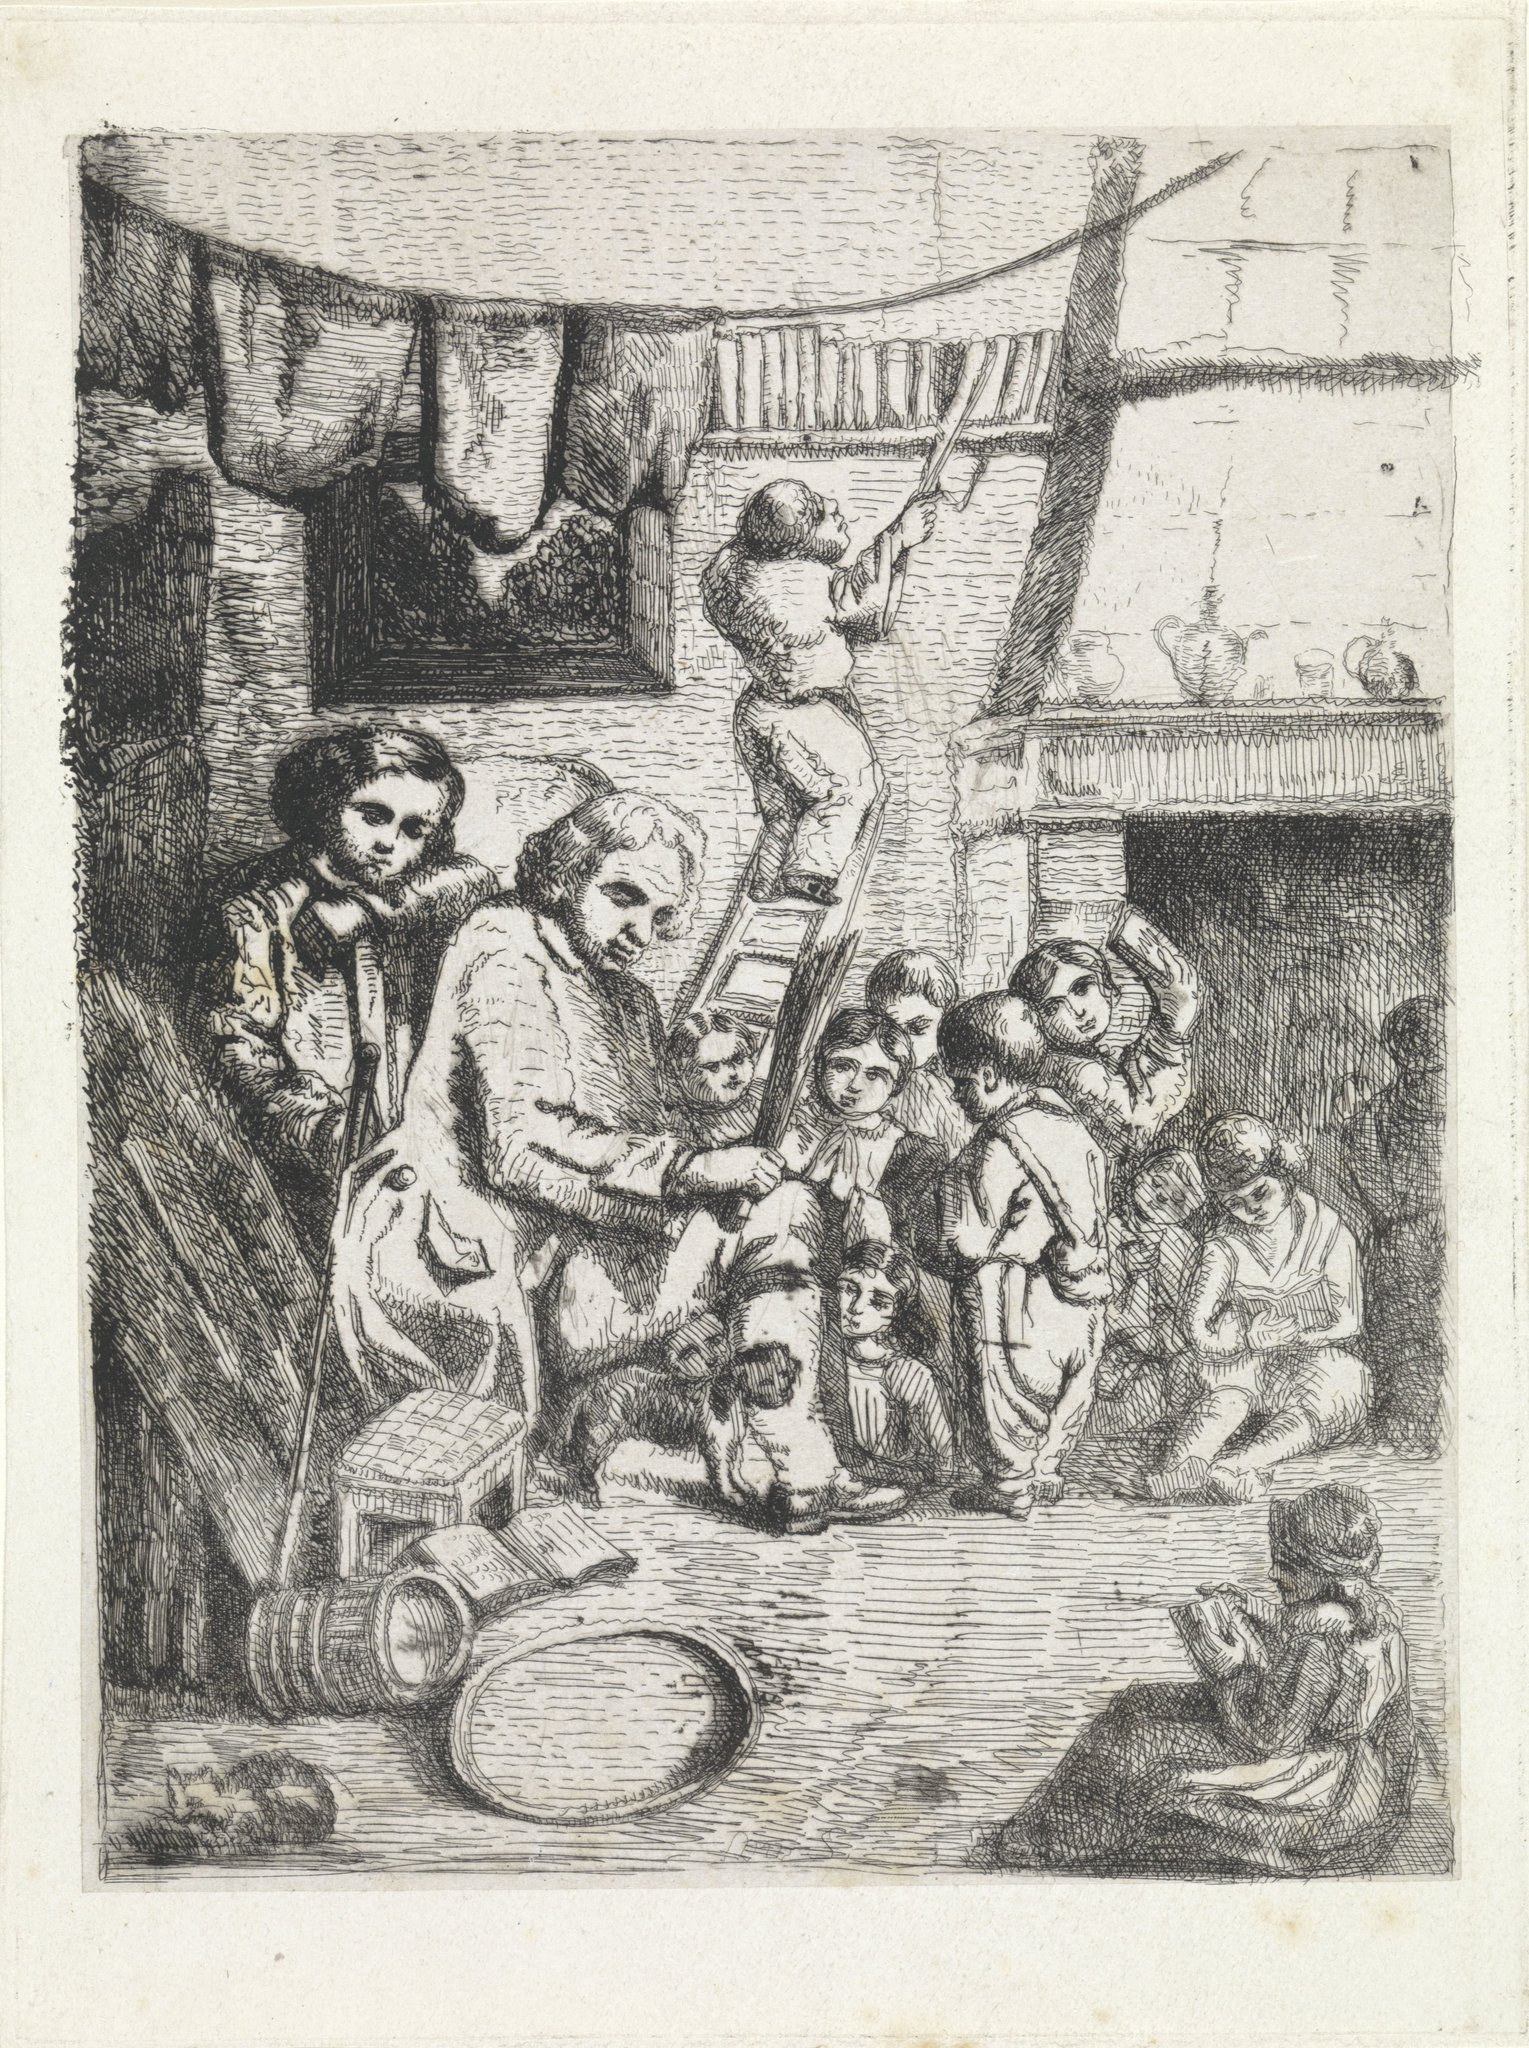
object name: print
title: Schoolmeester omringd door kinderen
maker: arnoud schaepkens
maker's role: print maker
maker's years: 1816-1904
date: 1831-1904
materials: paper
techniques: drypoint, etching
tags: teacher and pupil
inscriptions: collector's mark: Lugt 2228